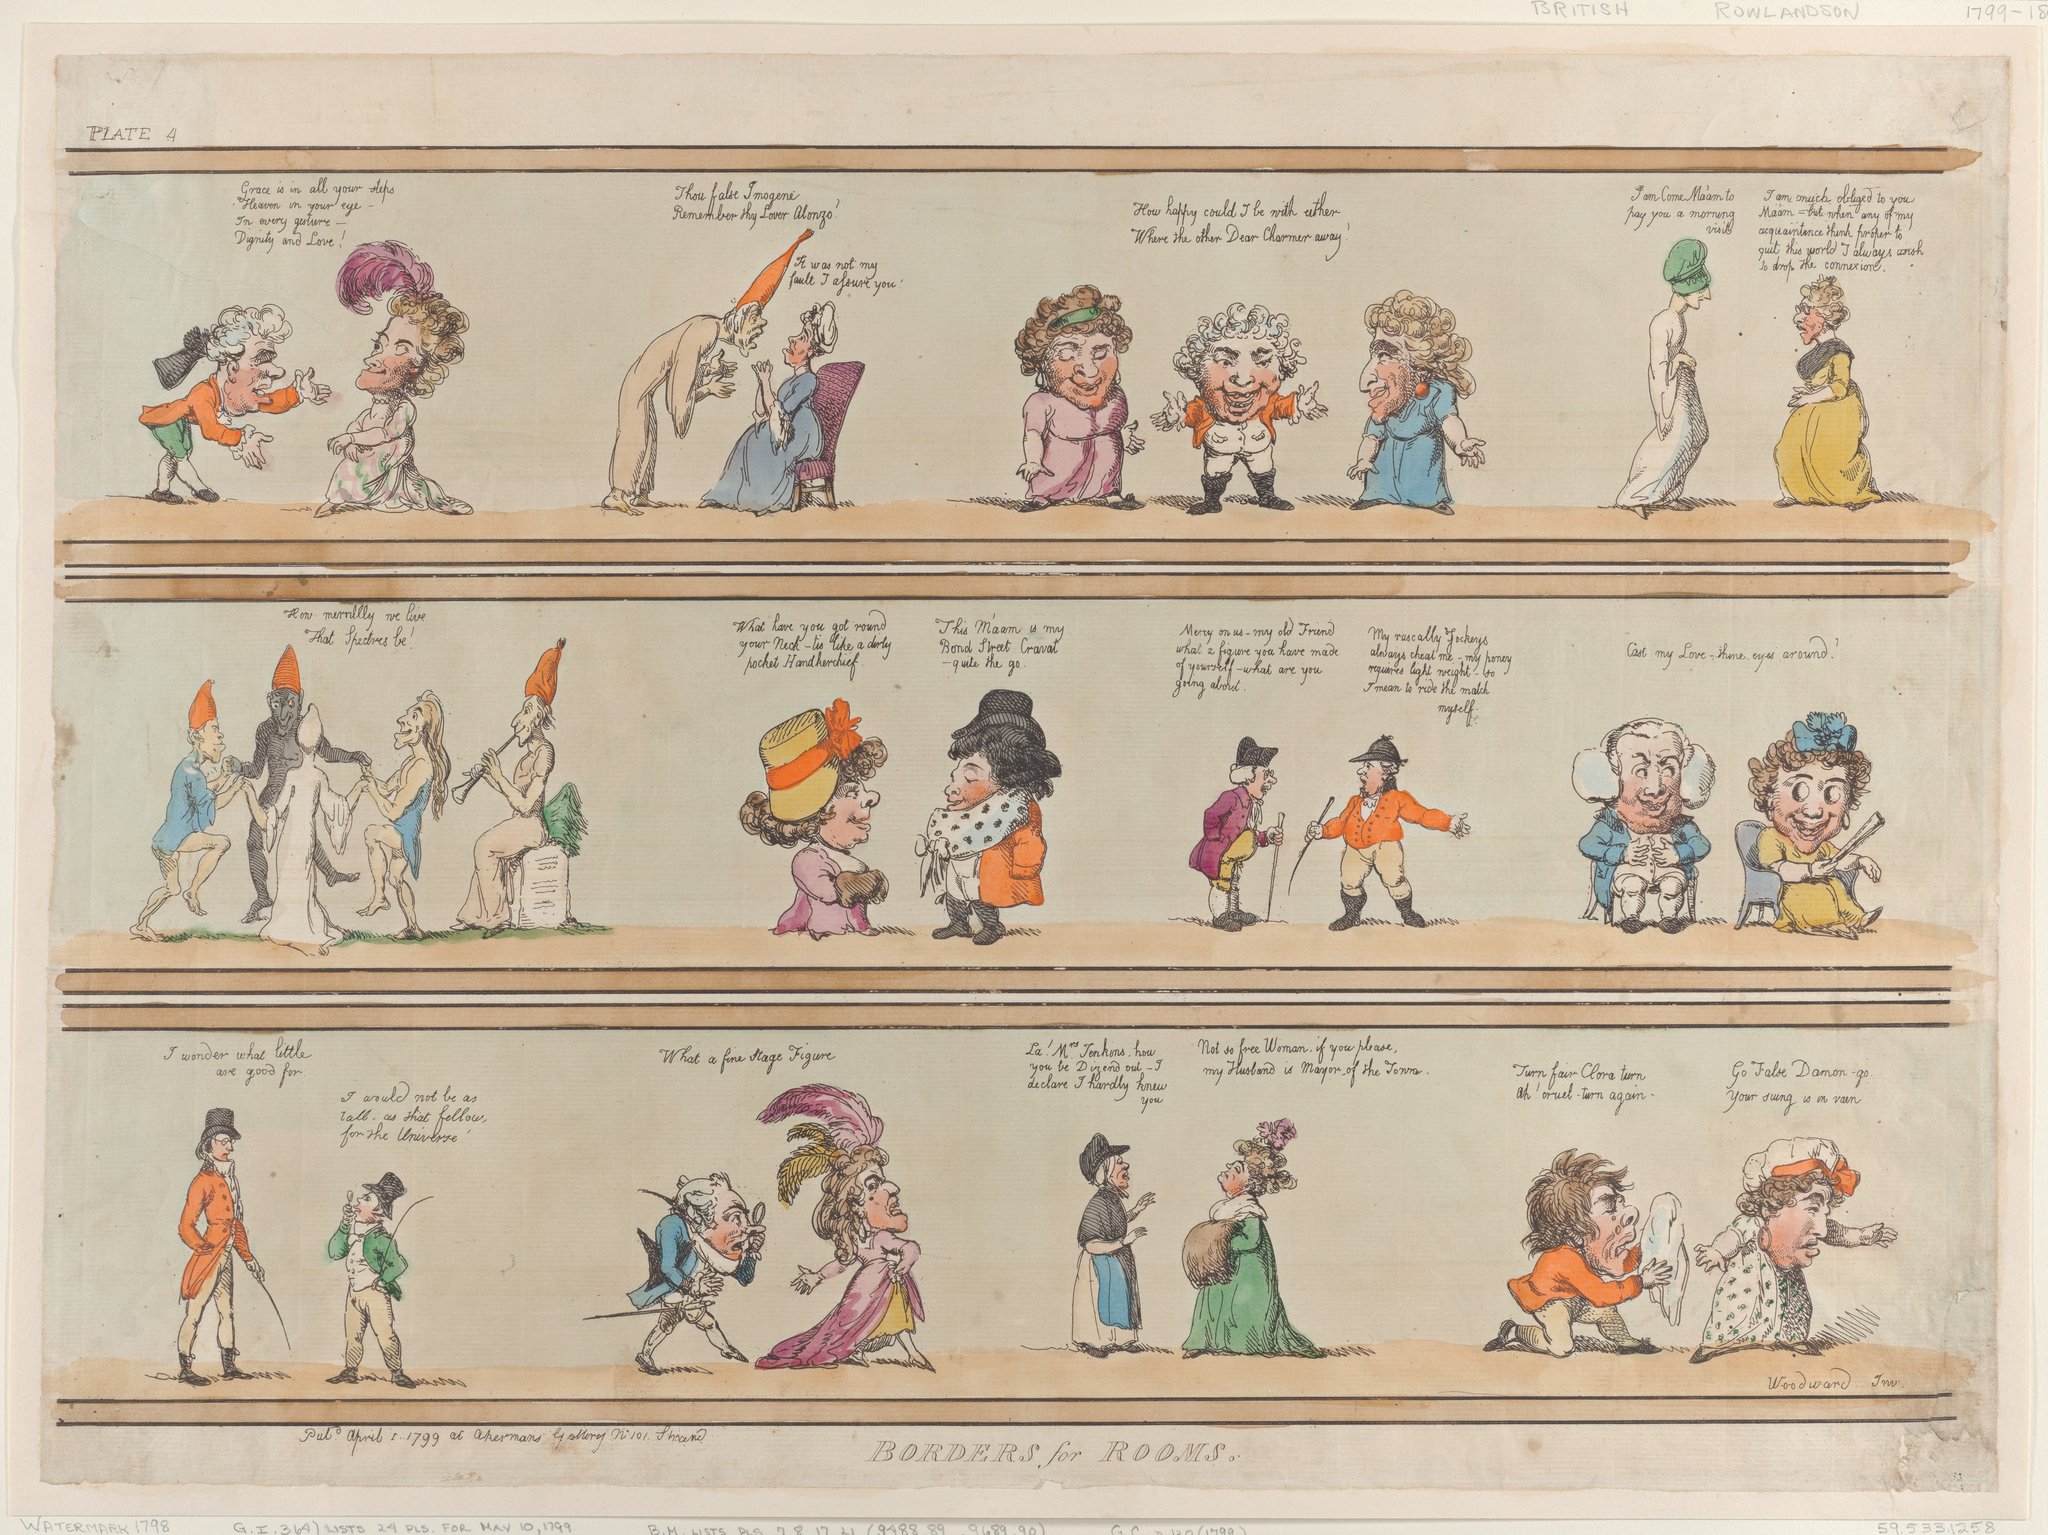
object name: print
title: Borders for Rooms, Plate 4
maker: thomas rowlandson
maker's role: artist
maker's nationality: british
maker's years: 1757-1827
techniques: etching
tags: satire,men,women